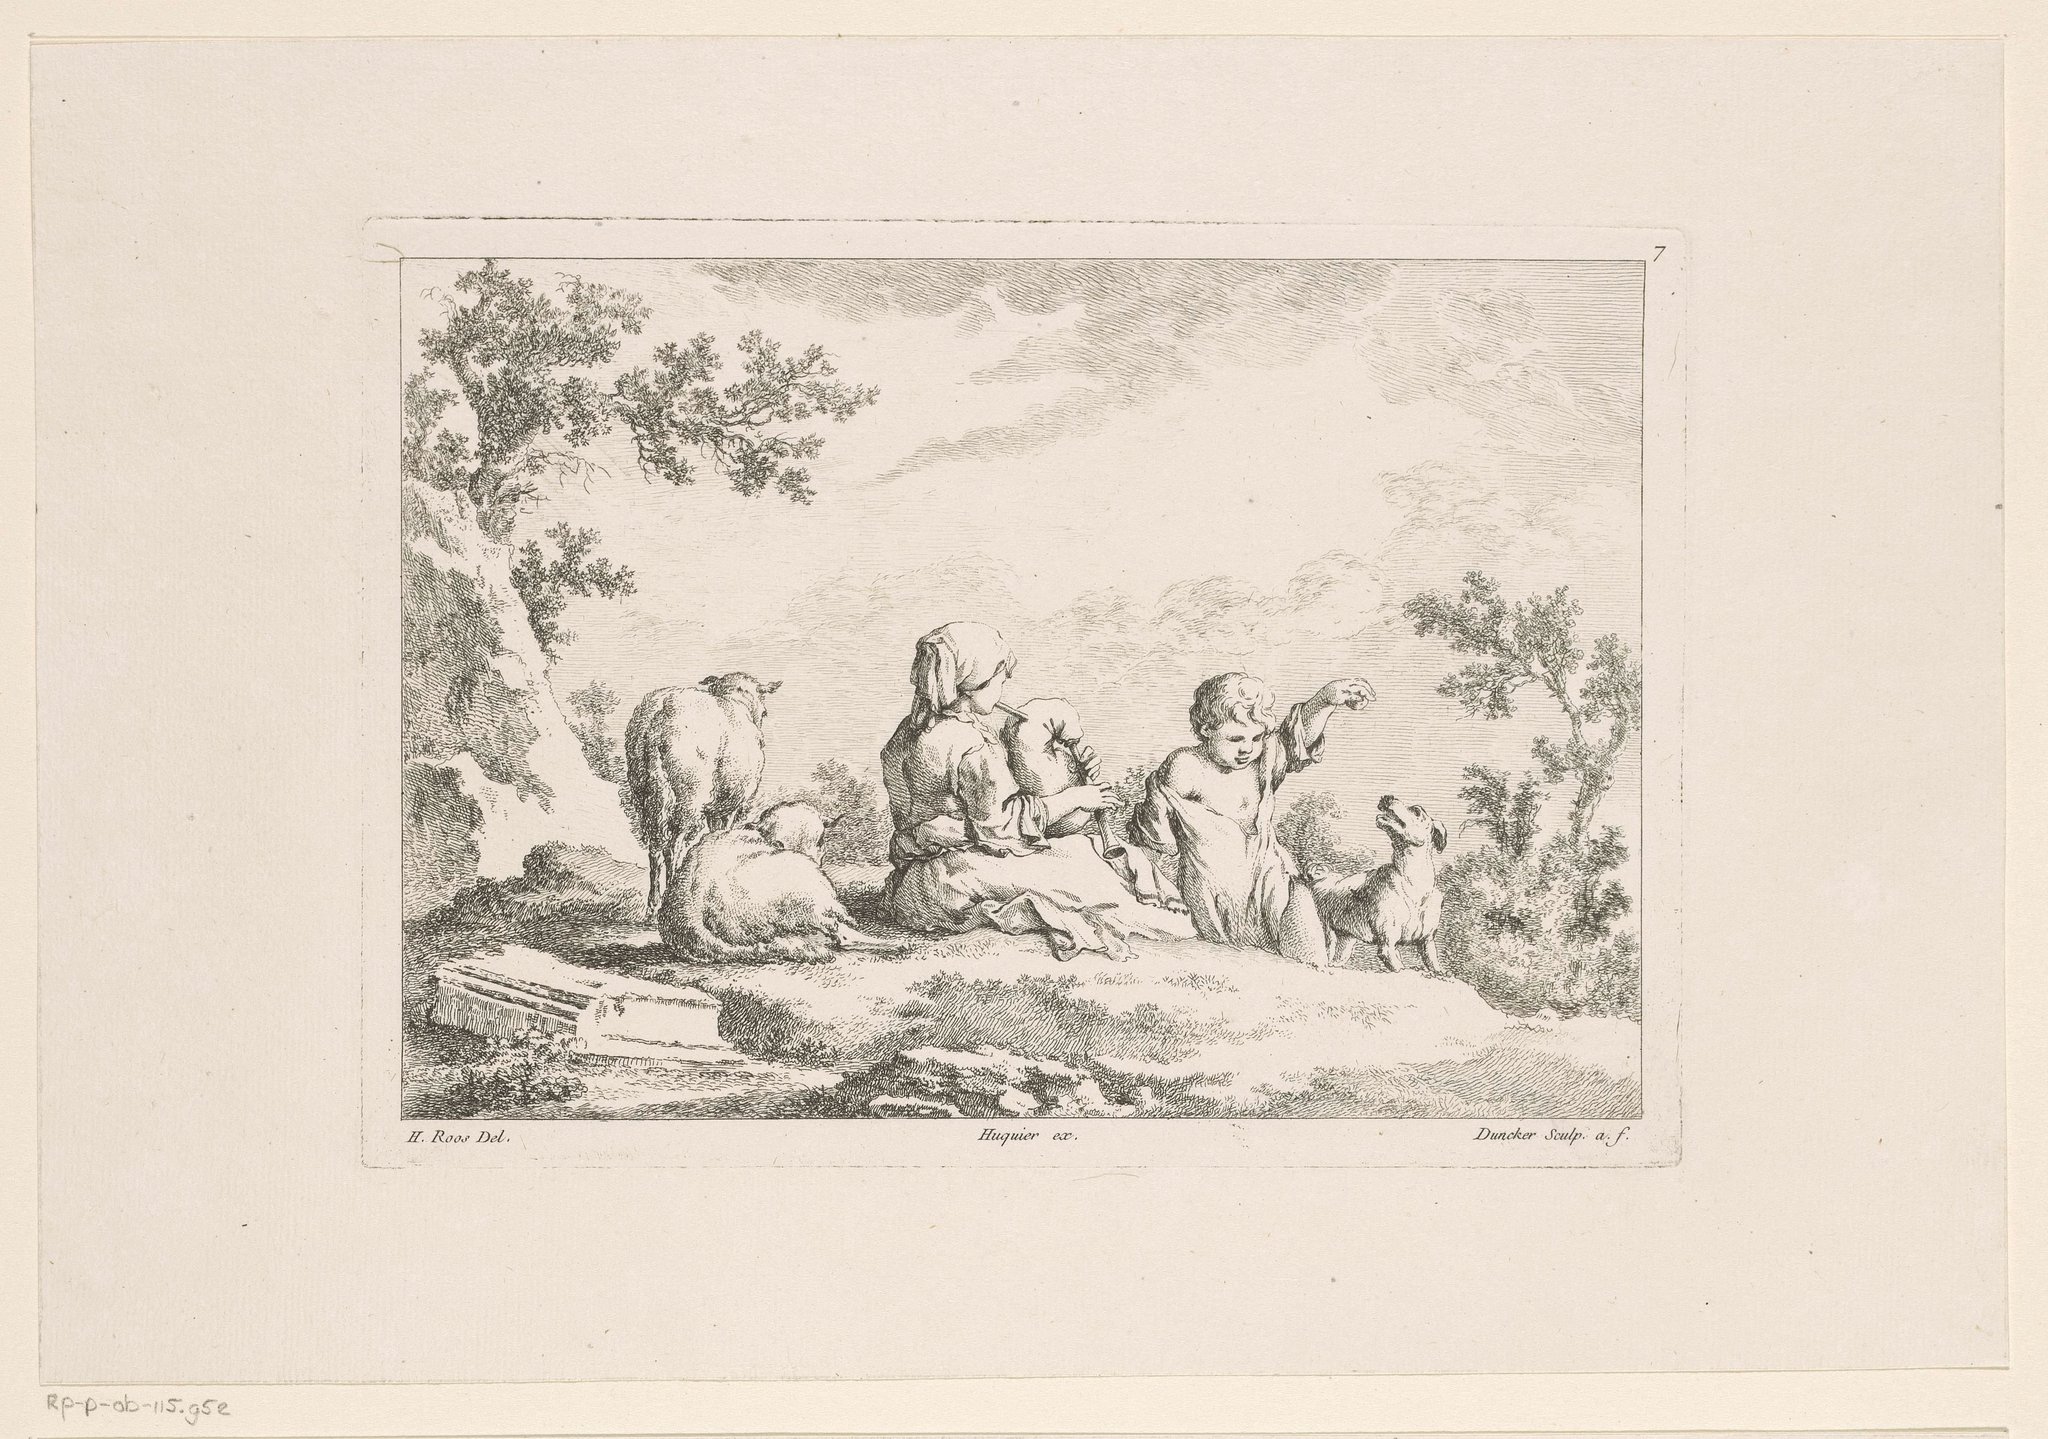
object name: print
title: Vrouw met doedelzak en dansend kind omringd door schapen en een hond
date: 1769-1772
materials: paper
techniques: etching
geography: paris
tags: bagpipe, musette, child, sheep, landscapes - hh - ideal landscapes, dog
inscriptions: collector's mark: Lugt 240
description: Onderdeel van een serie van acht prenten.